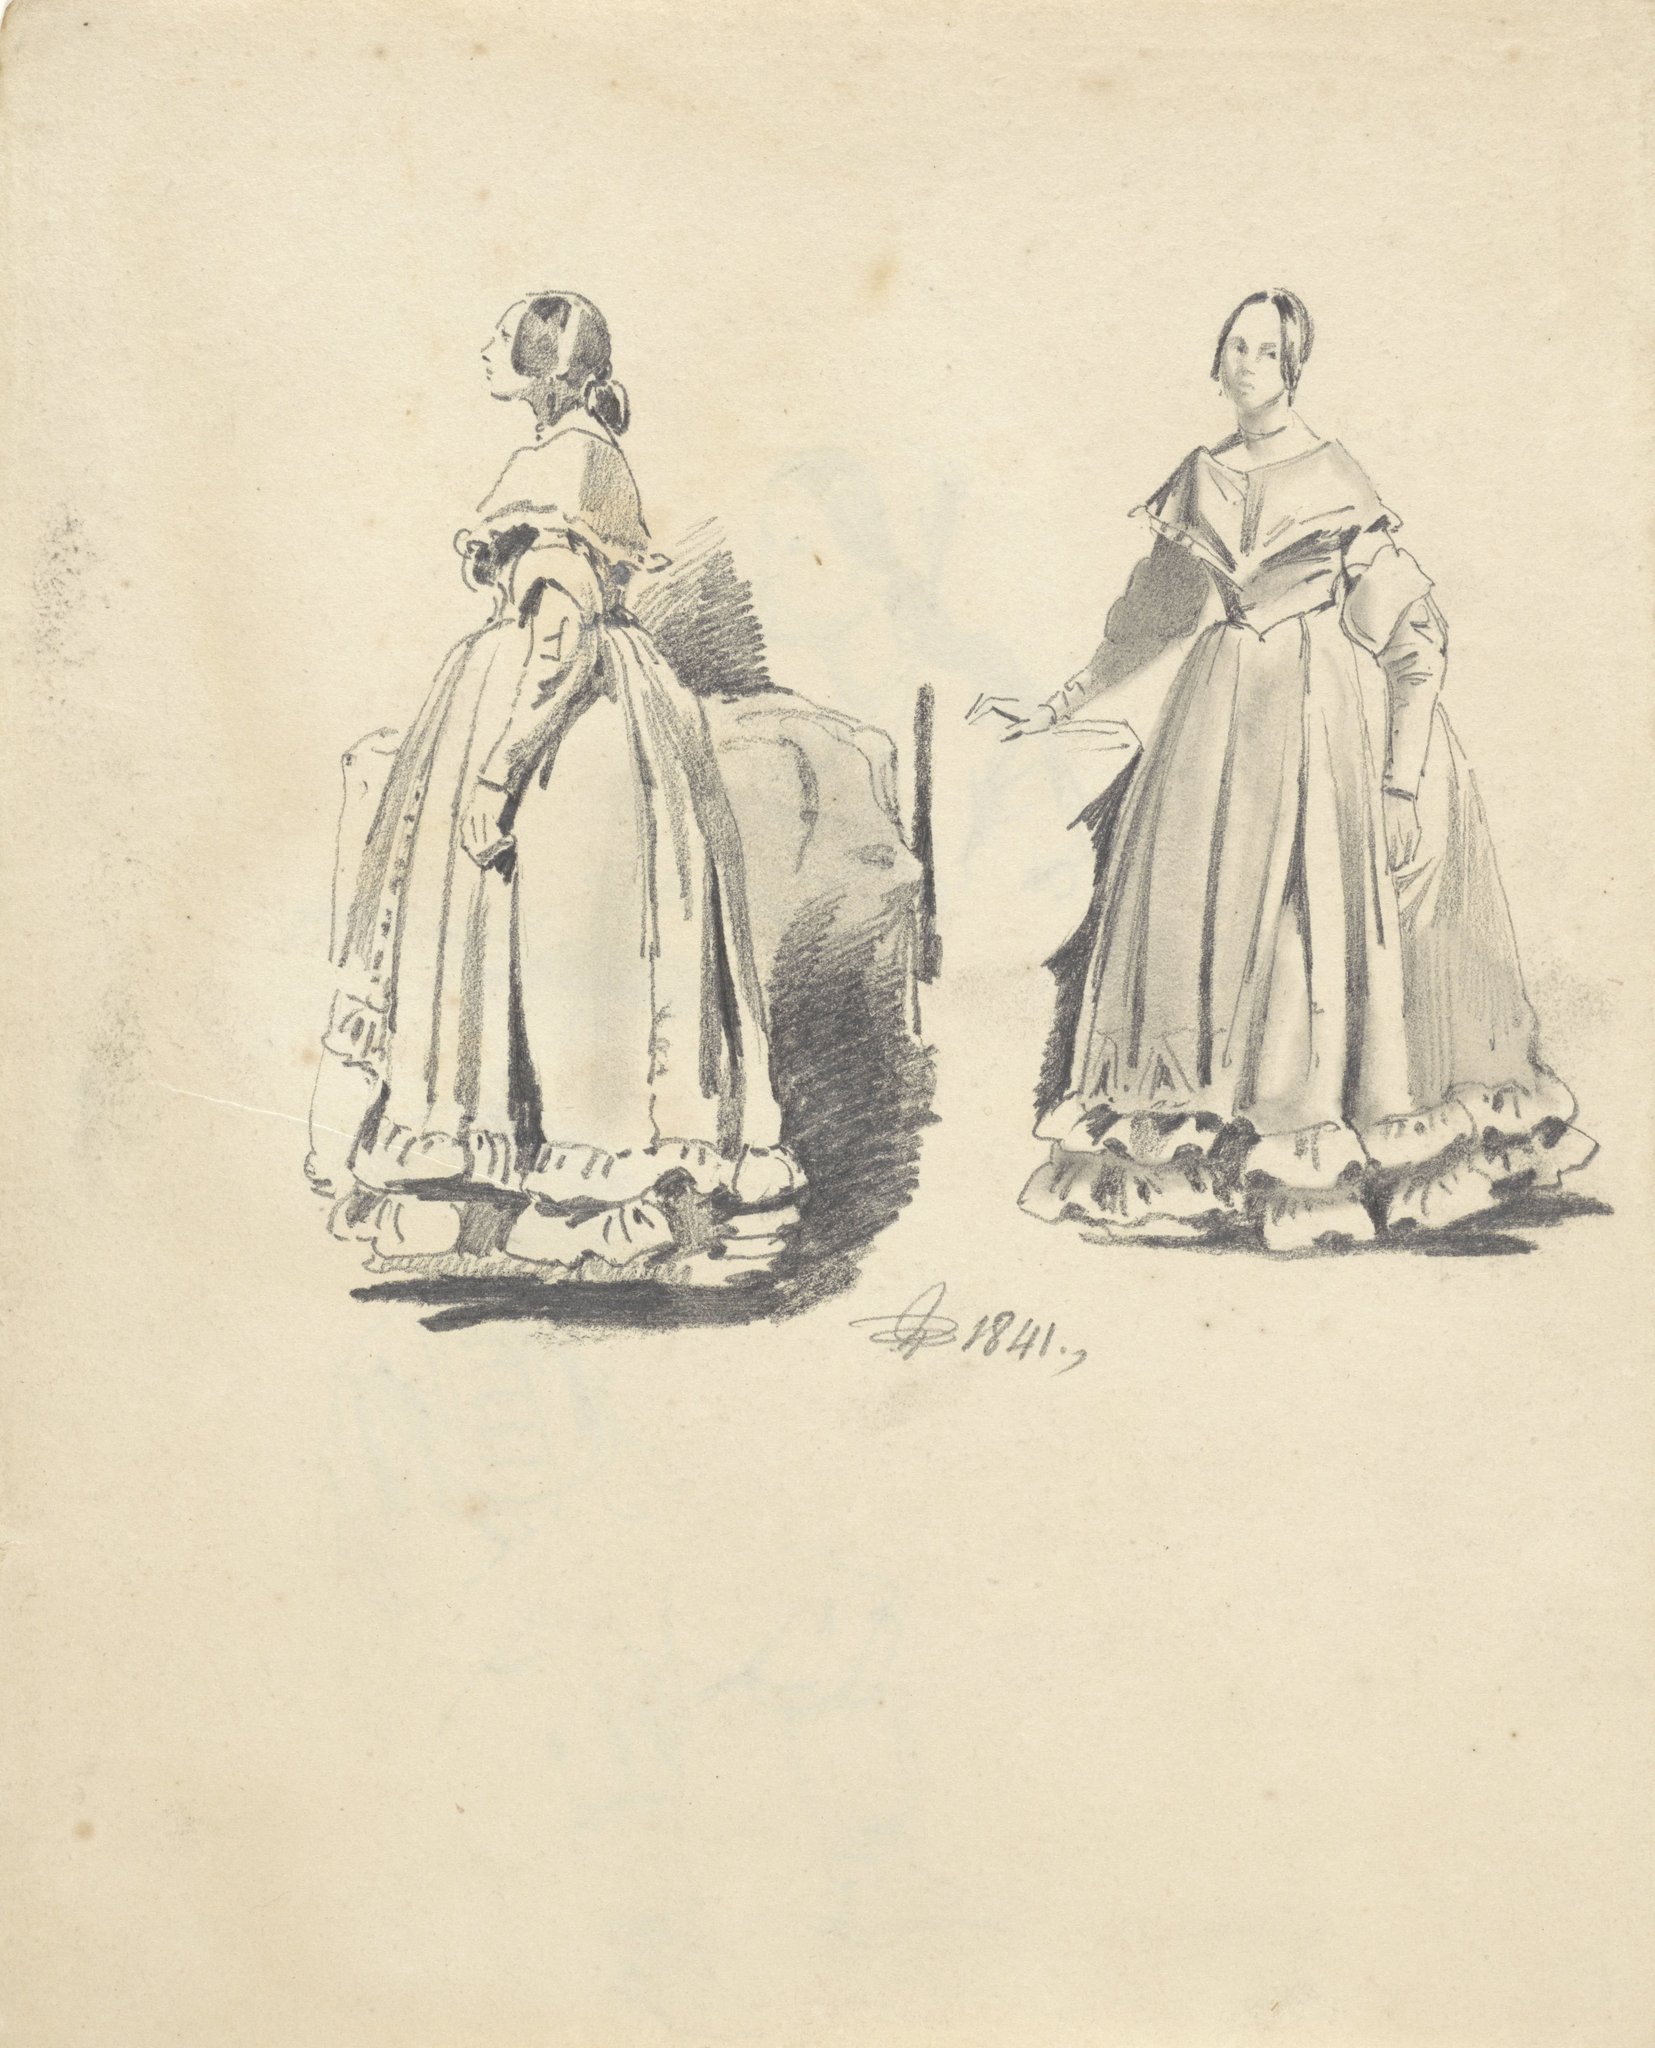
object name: drawing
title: Twee studies van een vrouw staande bij een tafel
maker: pieter van loon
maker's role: draughtsman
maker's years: 1801-1873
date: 1841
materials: paper, pencil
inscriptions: date: ‘1841’